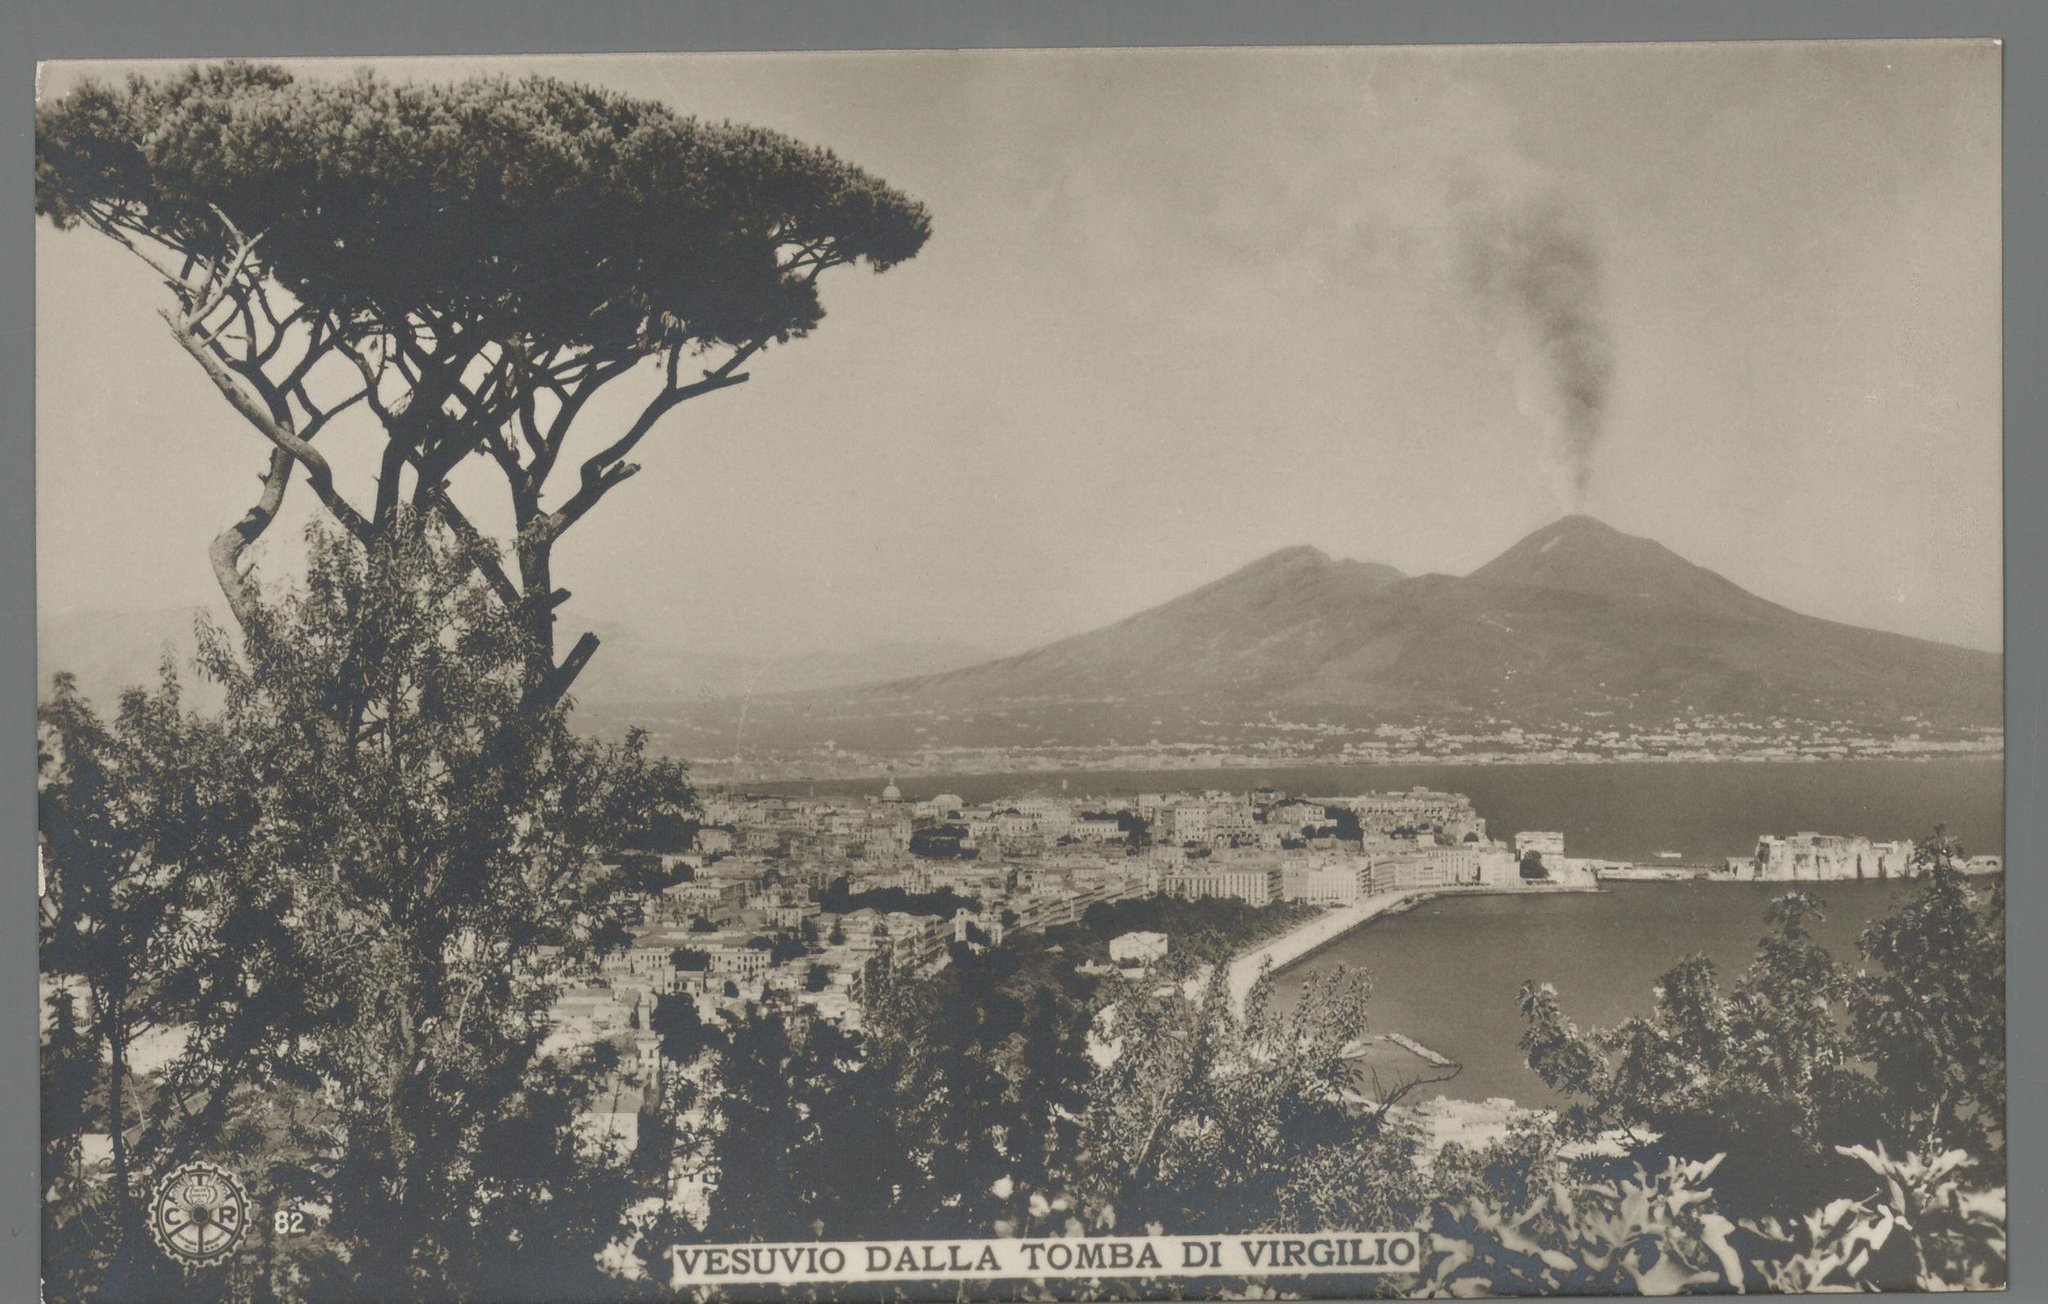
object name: ansichtkaart, prentbriefkaart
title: Vesuvio dalla Tomba di Virgilio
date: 1906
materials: photographic support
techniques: photography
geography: naples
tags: landscapes with waters, waterscapes, seascapes (in the temperate zone), eruption (of volcano), mount vesuvius, naples